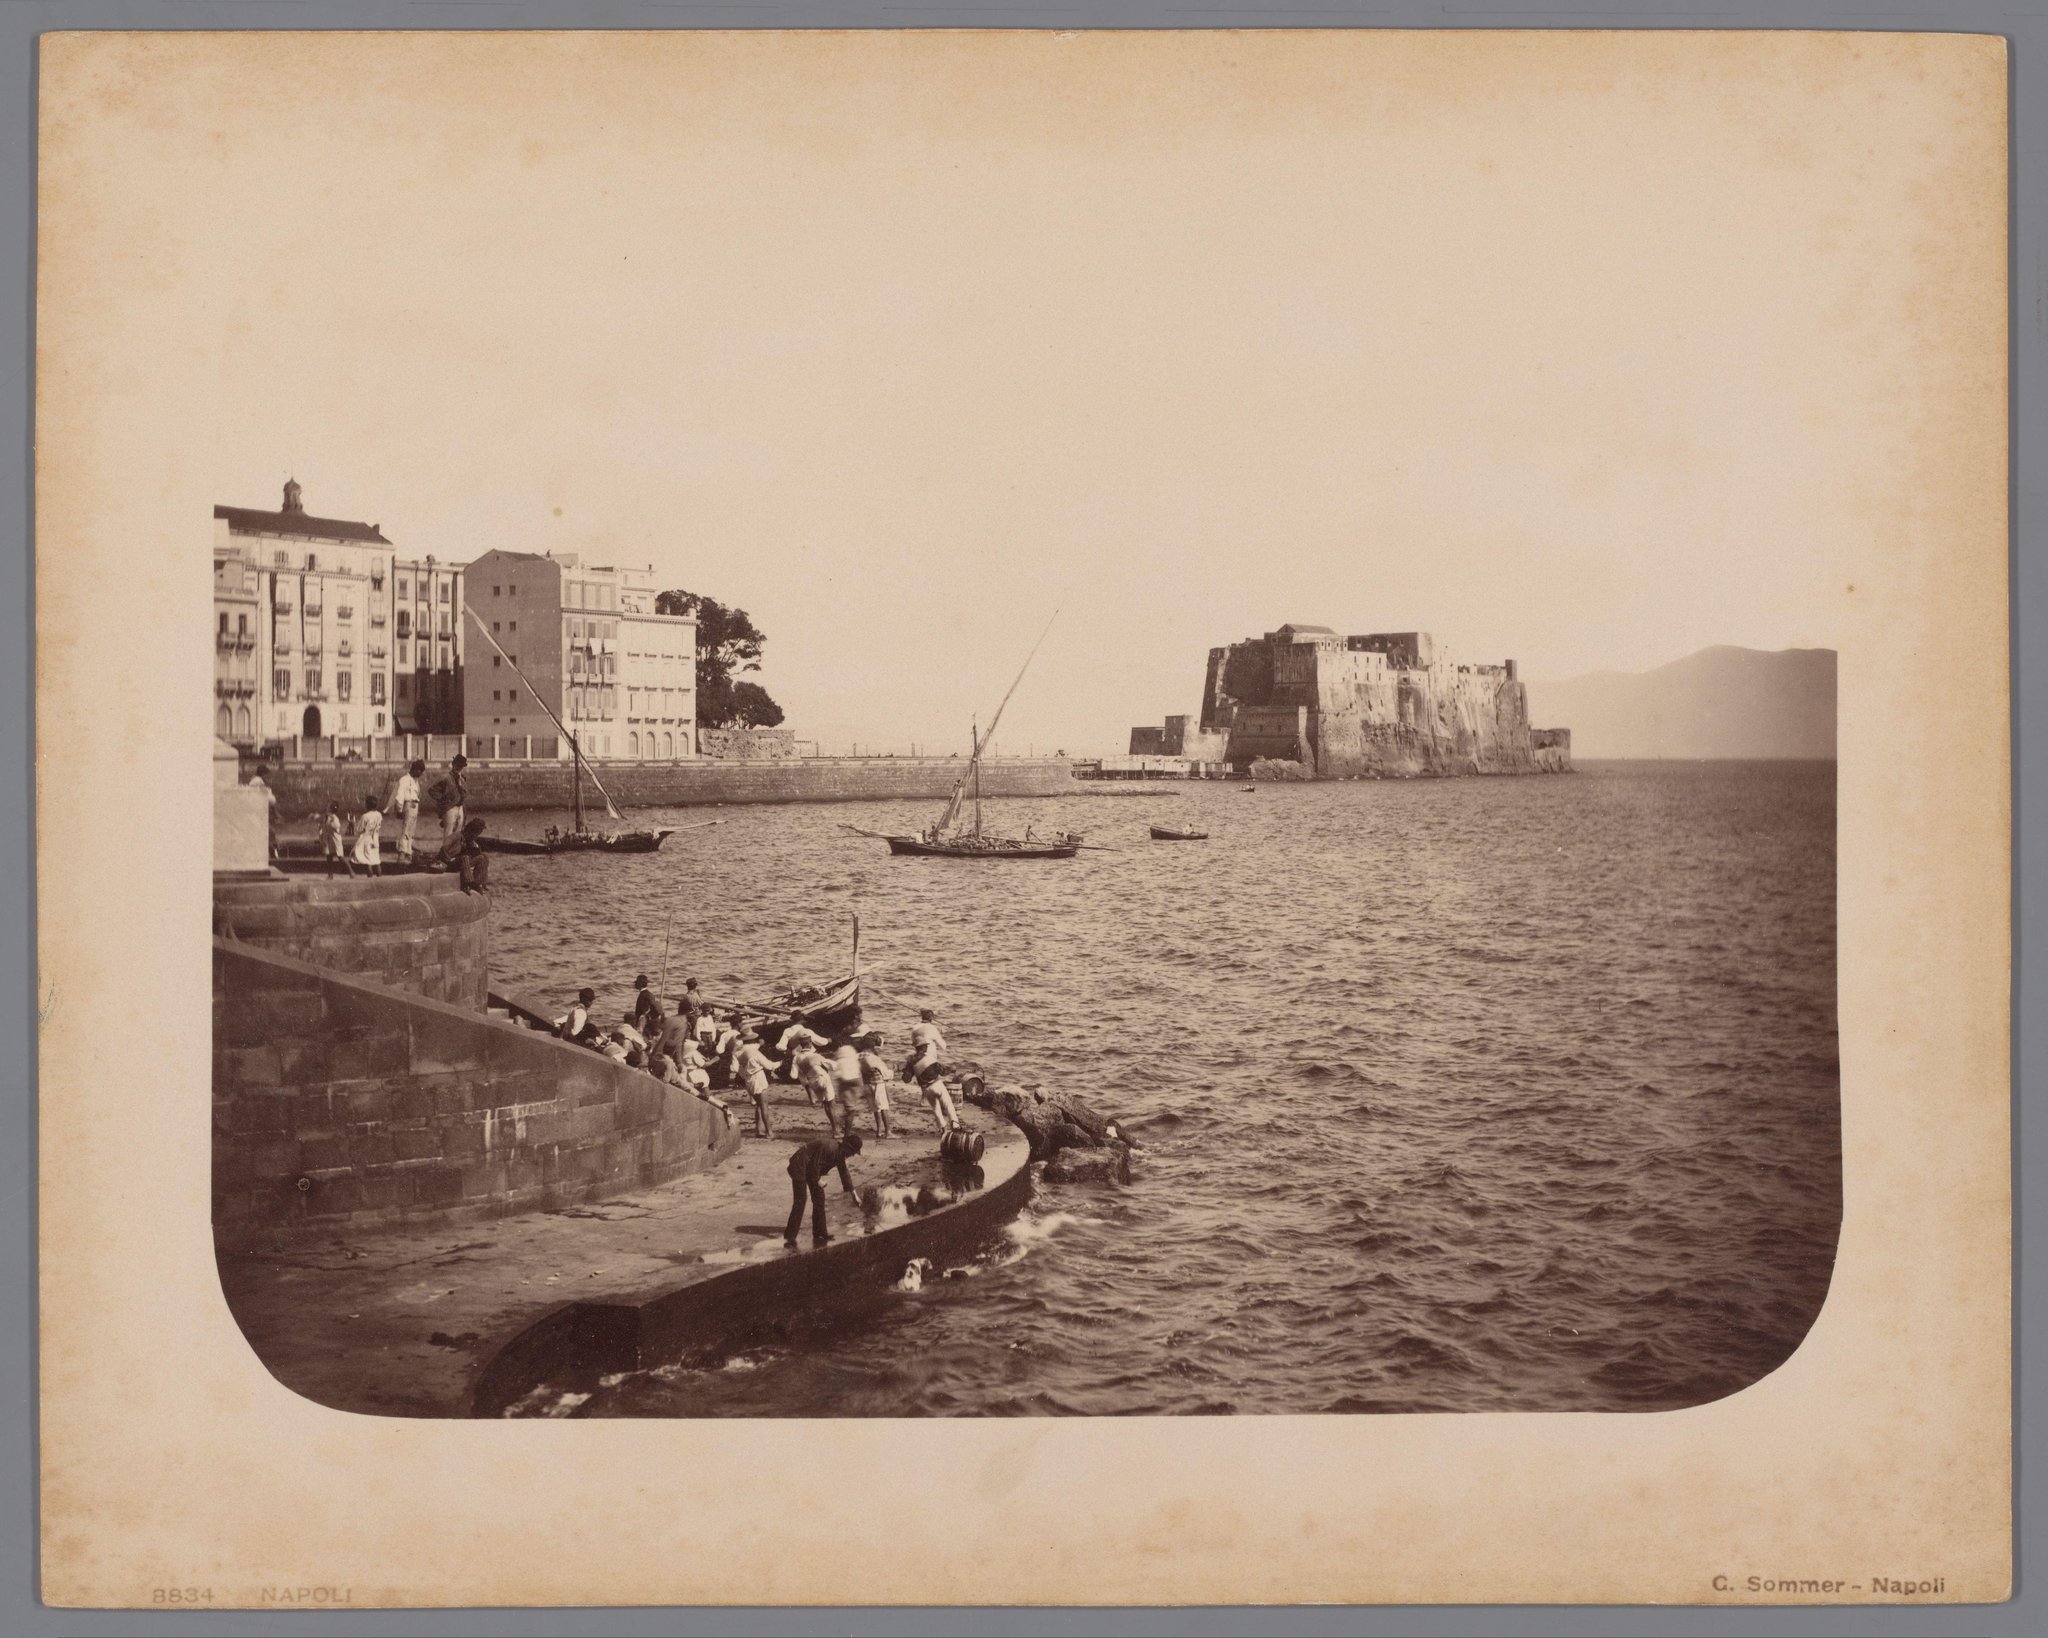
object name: photograph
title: Gezicht op de baai van Napels en Castel dell'Ovo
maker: giorgio sommer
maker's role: fotograaf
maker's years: 1834-1914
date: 1857-1914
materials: cardboard, paper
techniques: albumen print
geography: naples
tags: gulf, bay, castle, quay, naples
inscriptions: number: ‘1385’, number: ‘8834’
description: Gezicht op Napels, burcht en baai van Napels. Aan de kust en op het water enkele vissersboten en mensen.